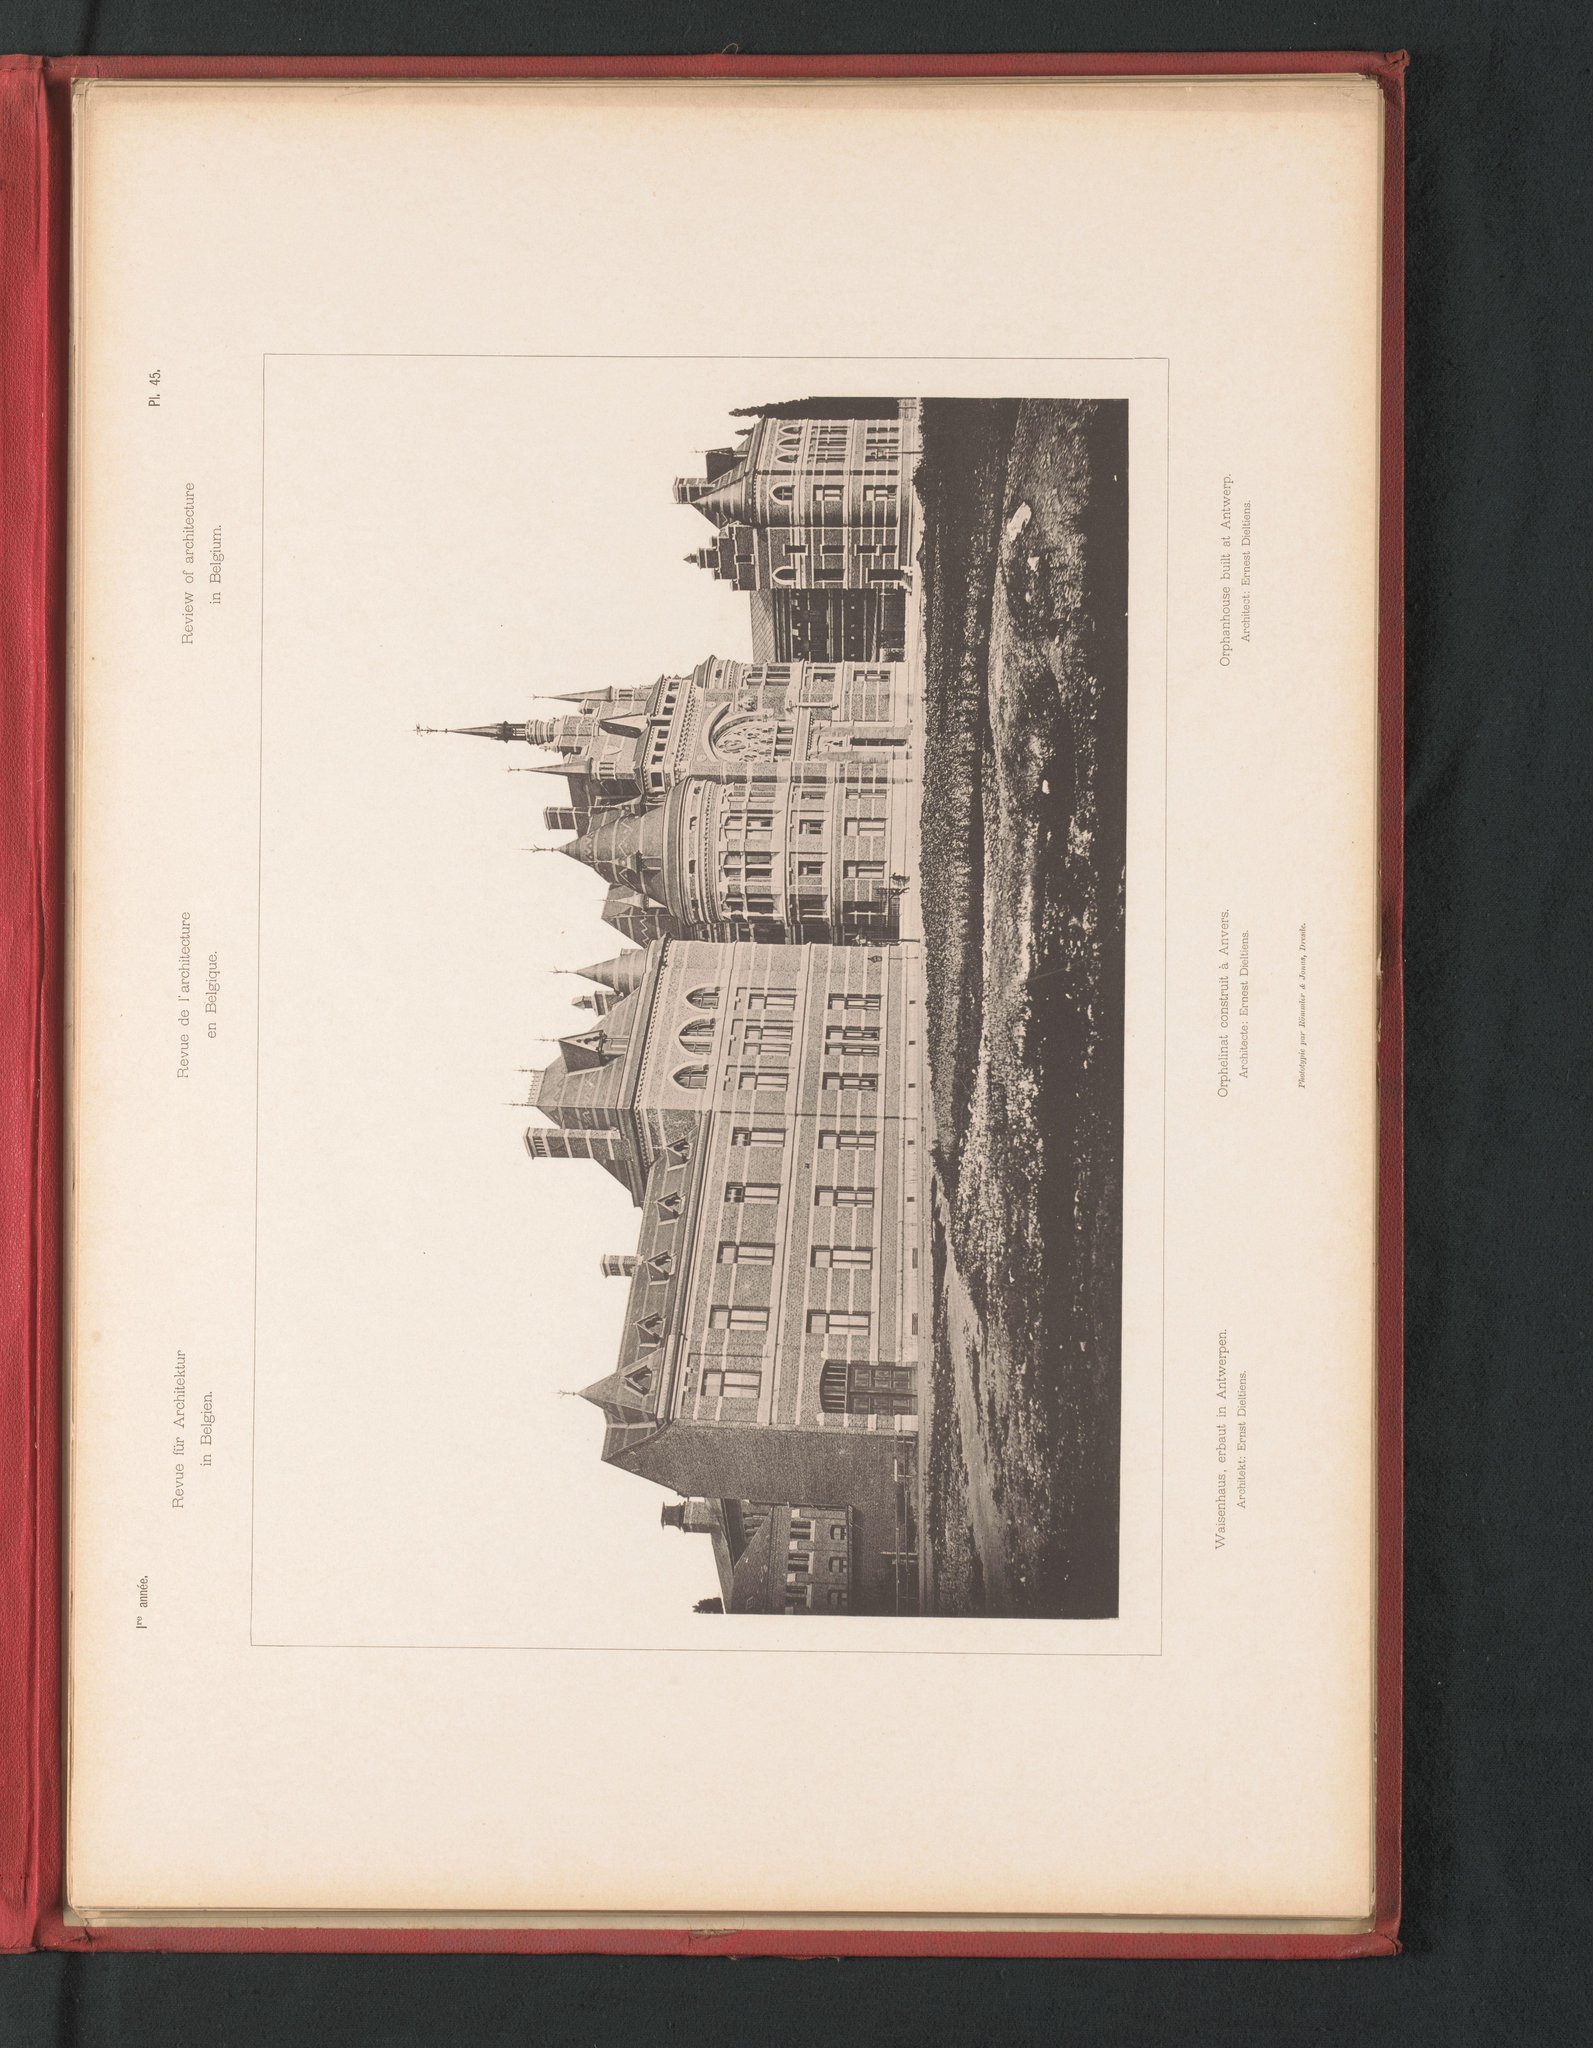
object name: photomechanical print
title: Gezicht op een weeshuis in Antwerpen, België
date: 1888-1893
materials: paper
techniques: photograph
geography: dresden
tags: orphanage, antwerp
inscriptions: inscription: ‘Architect: Ernest Dieltiens.’, inscription: ‘Architekt: Ernst Dieltiens.’, number: ‘Pl. 45.’, inscription: ‘1re annèe.’, inscription: ‘Architecte: Ernest Dieltiens.’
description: Deze prent maakt deel uit van een omslag met 110 prenten op 90 bladen en 18 tekstbladen.